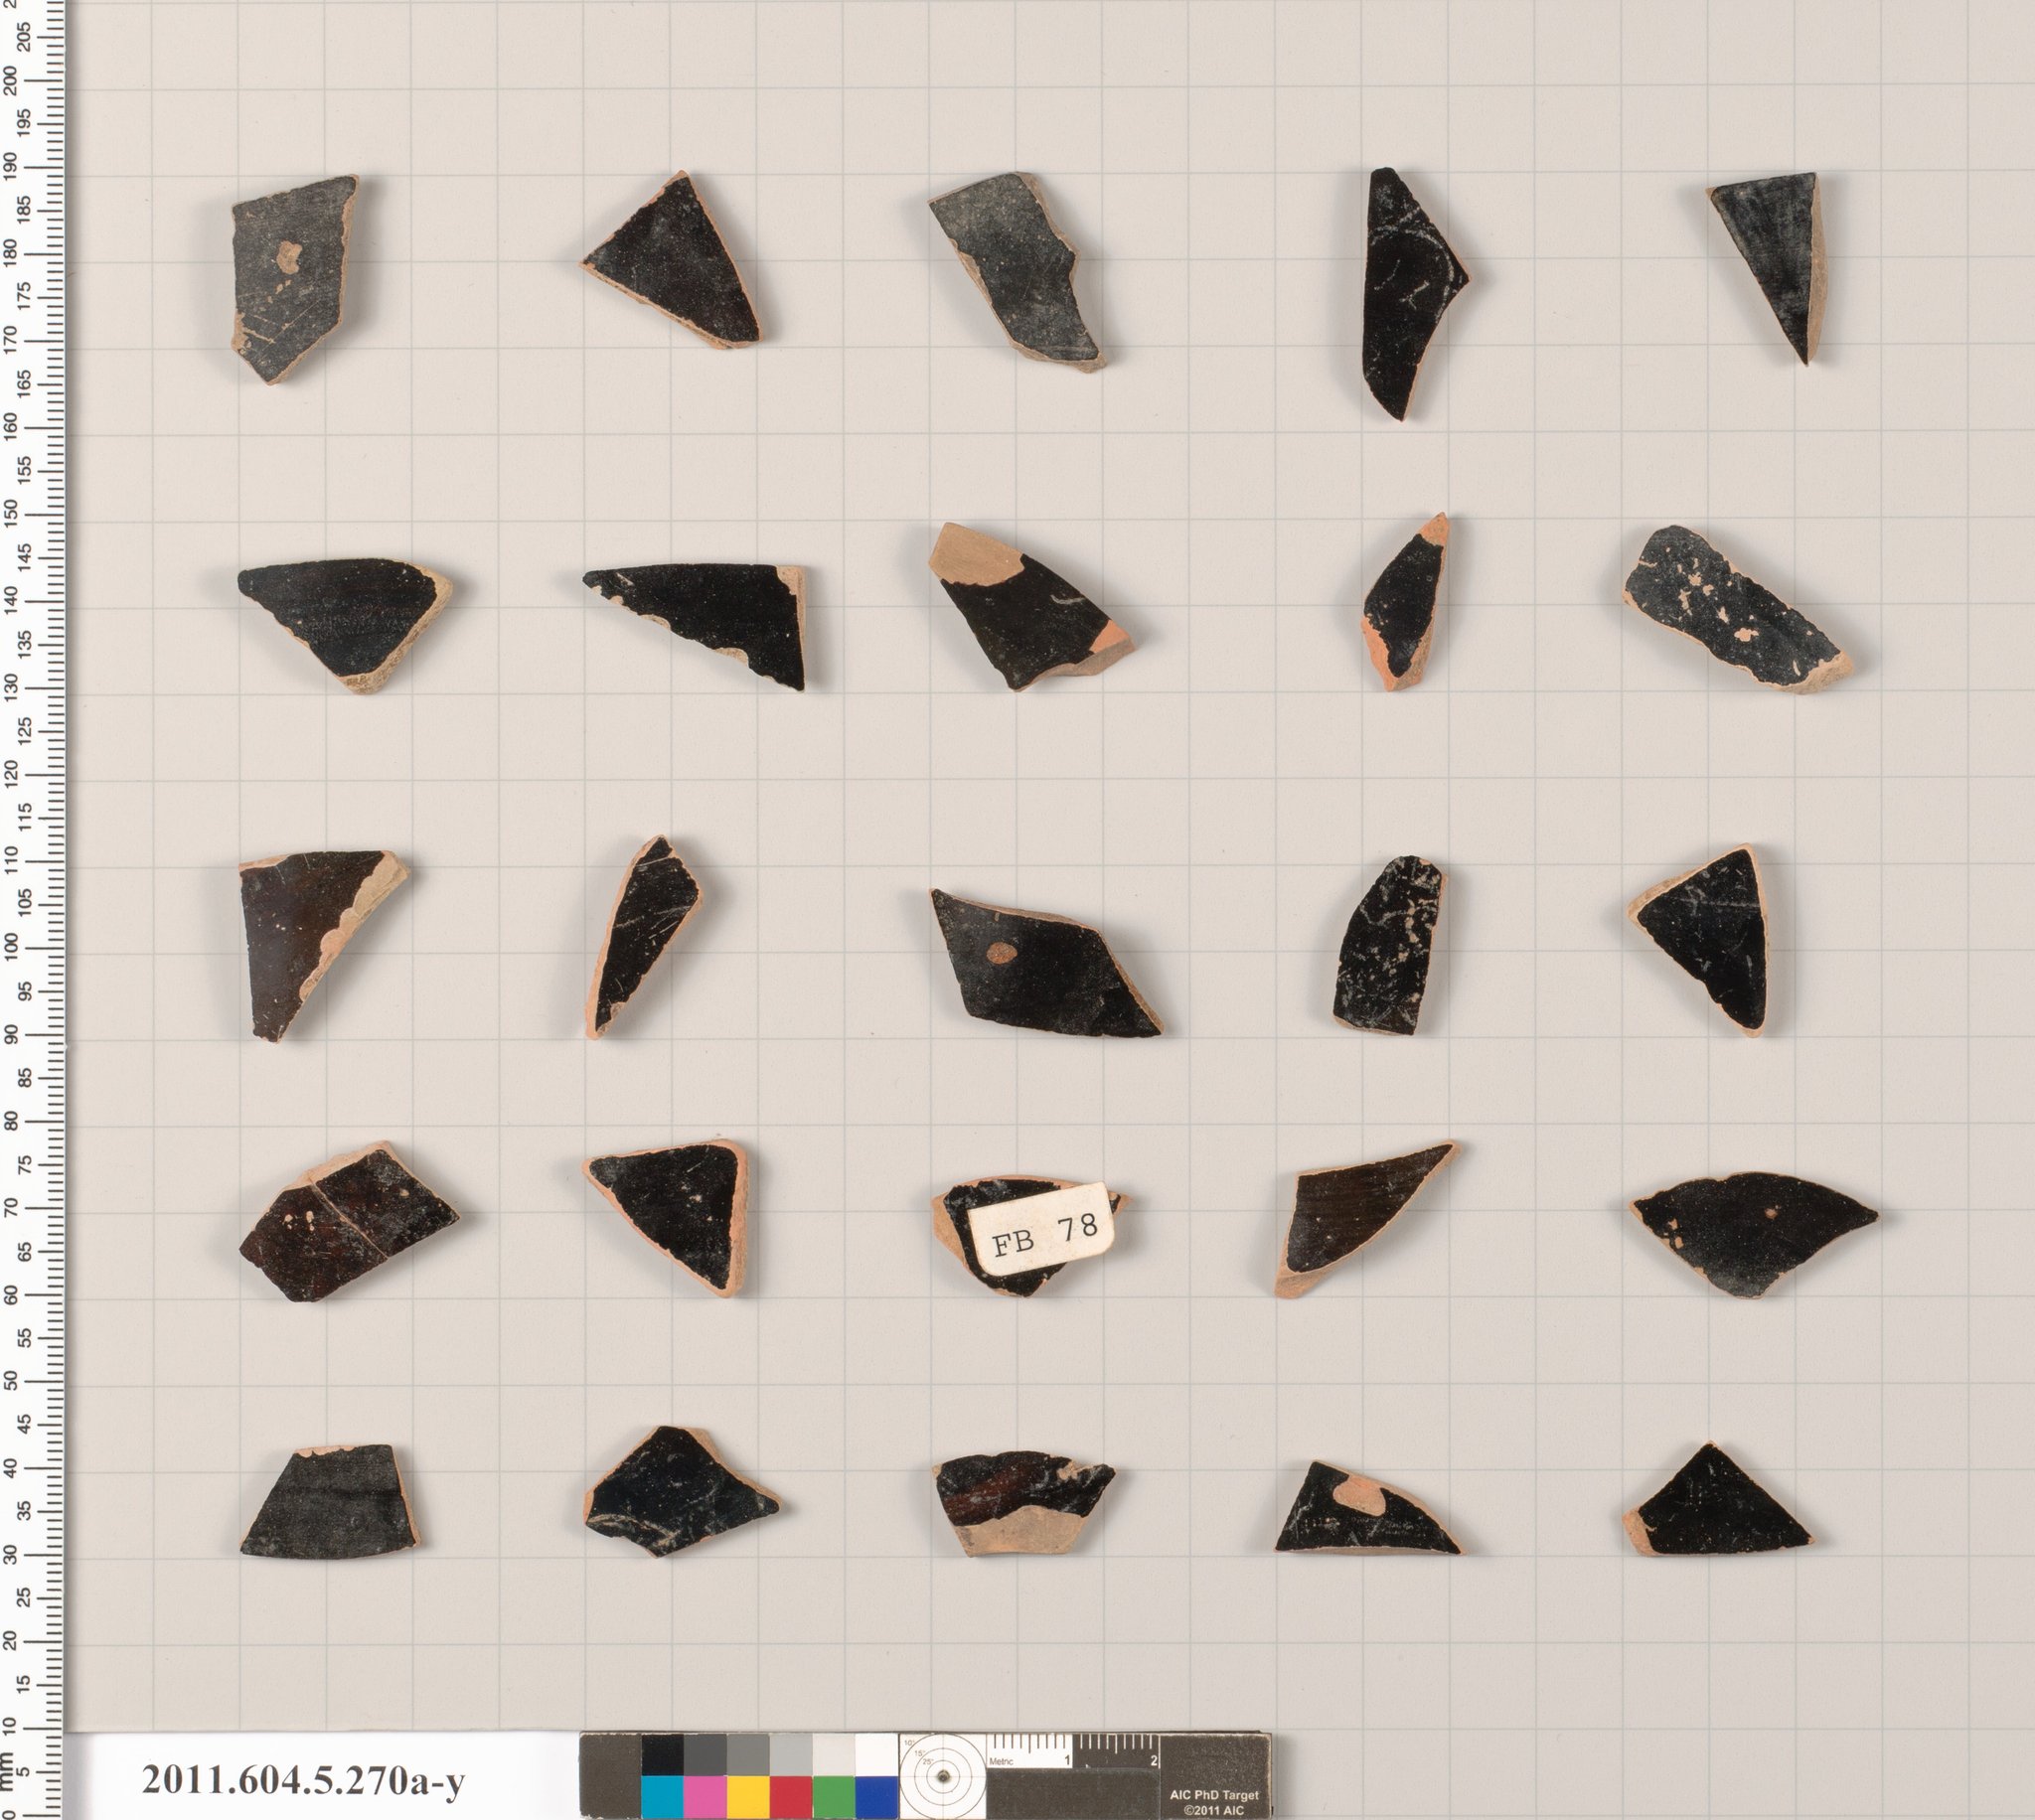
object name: kylix fragment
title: Terracotta fragments of kylikes (drinking cups)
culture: greek, attic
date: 600-401 BCE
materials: terracotta